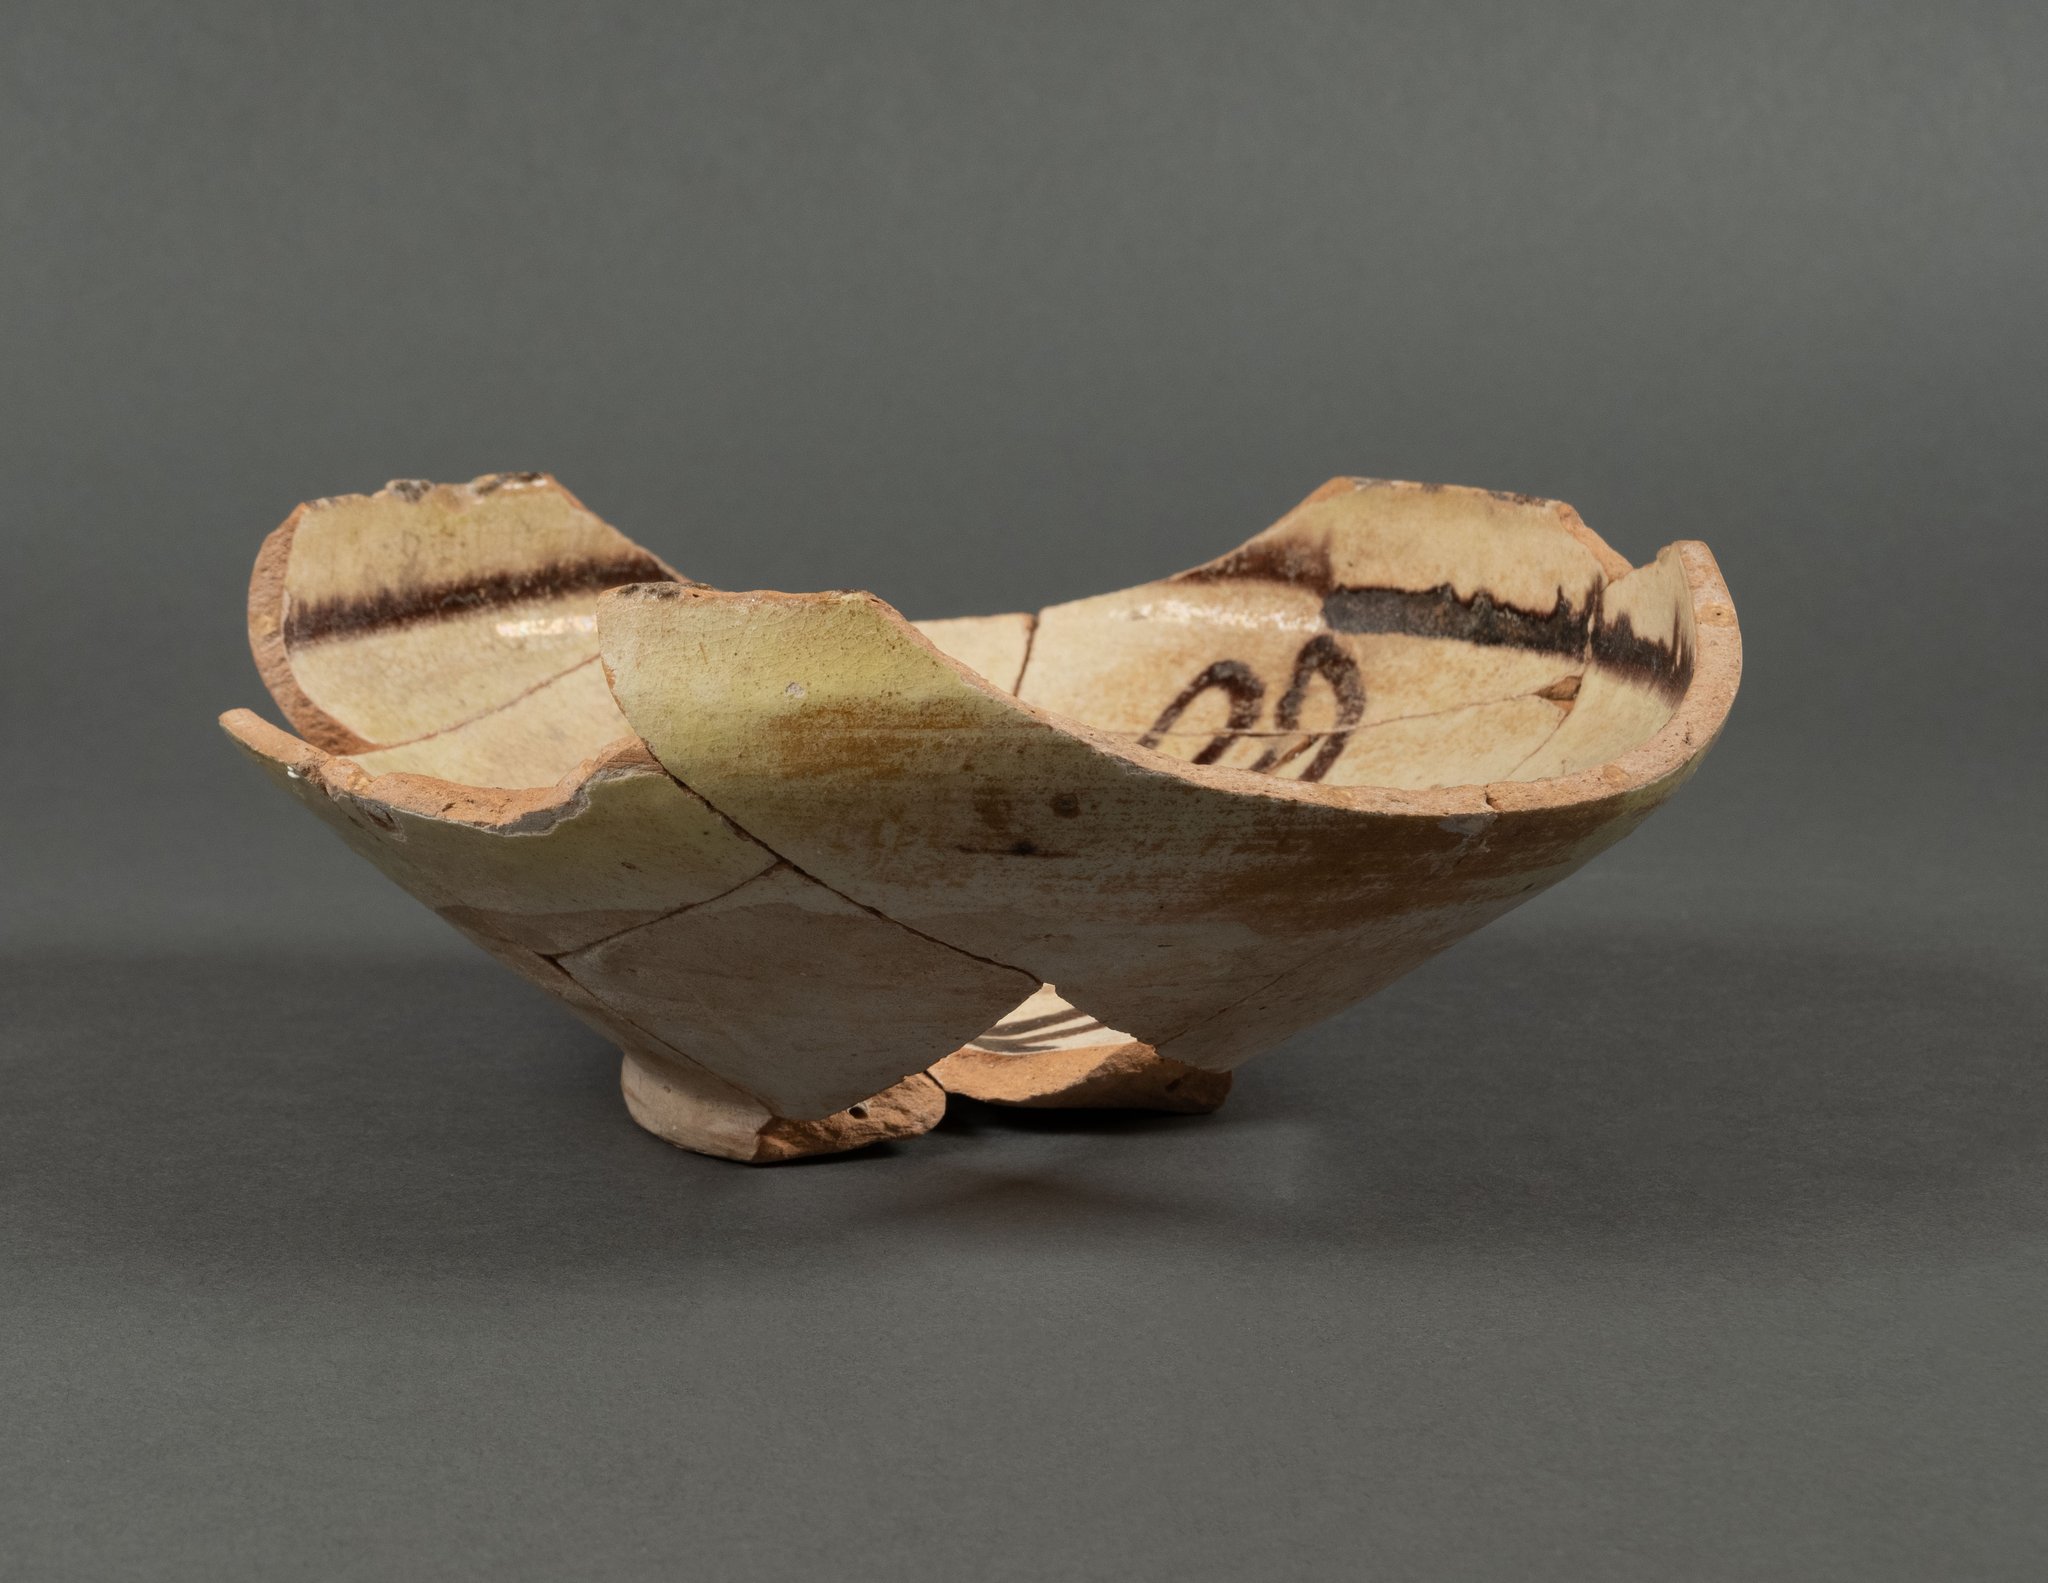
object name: bowl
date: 867-933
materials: earthenware, glaze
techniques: polychrome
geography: iran